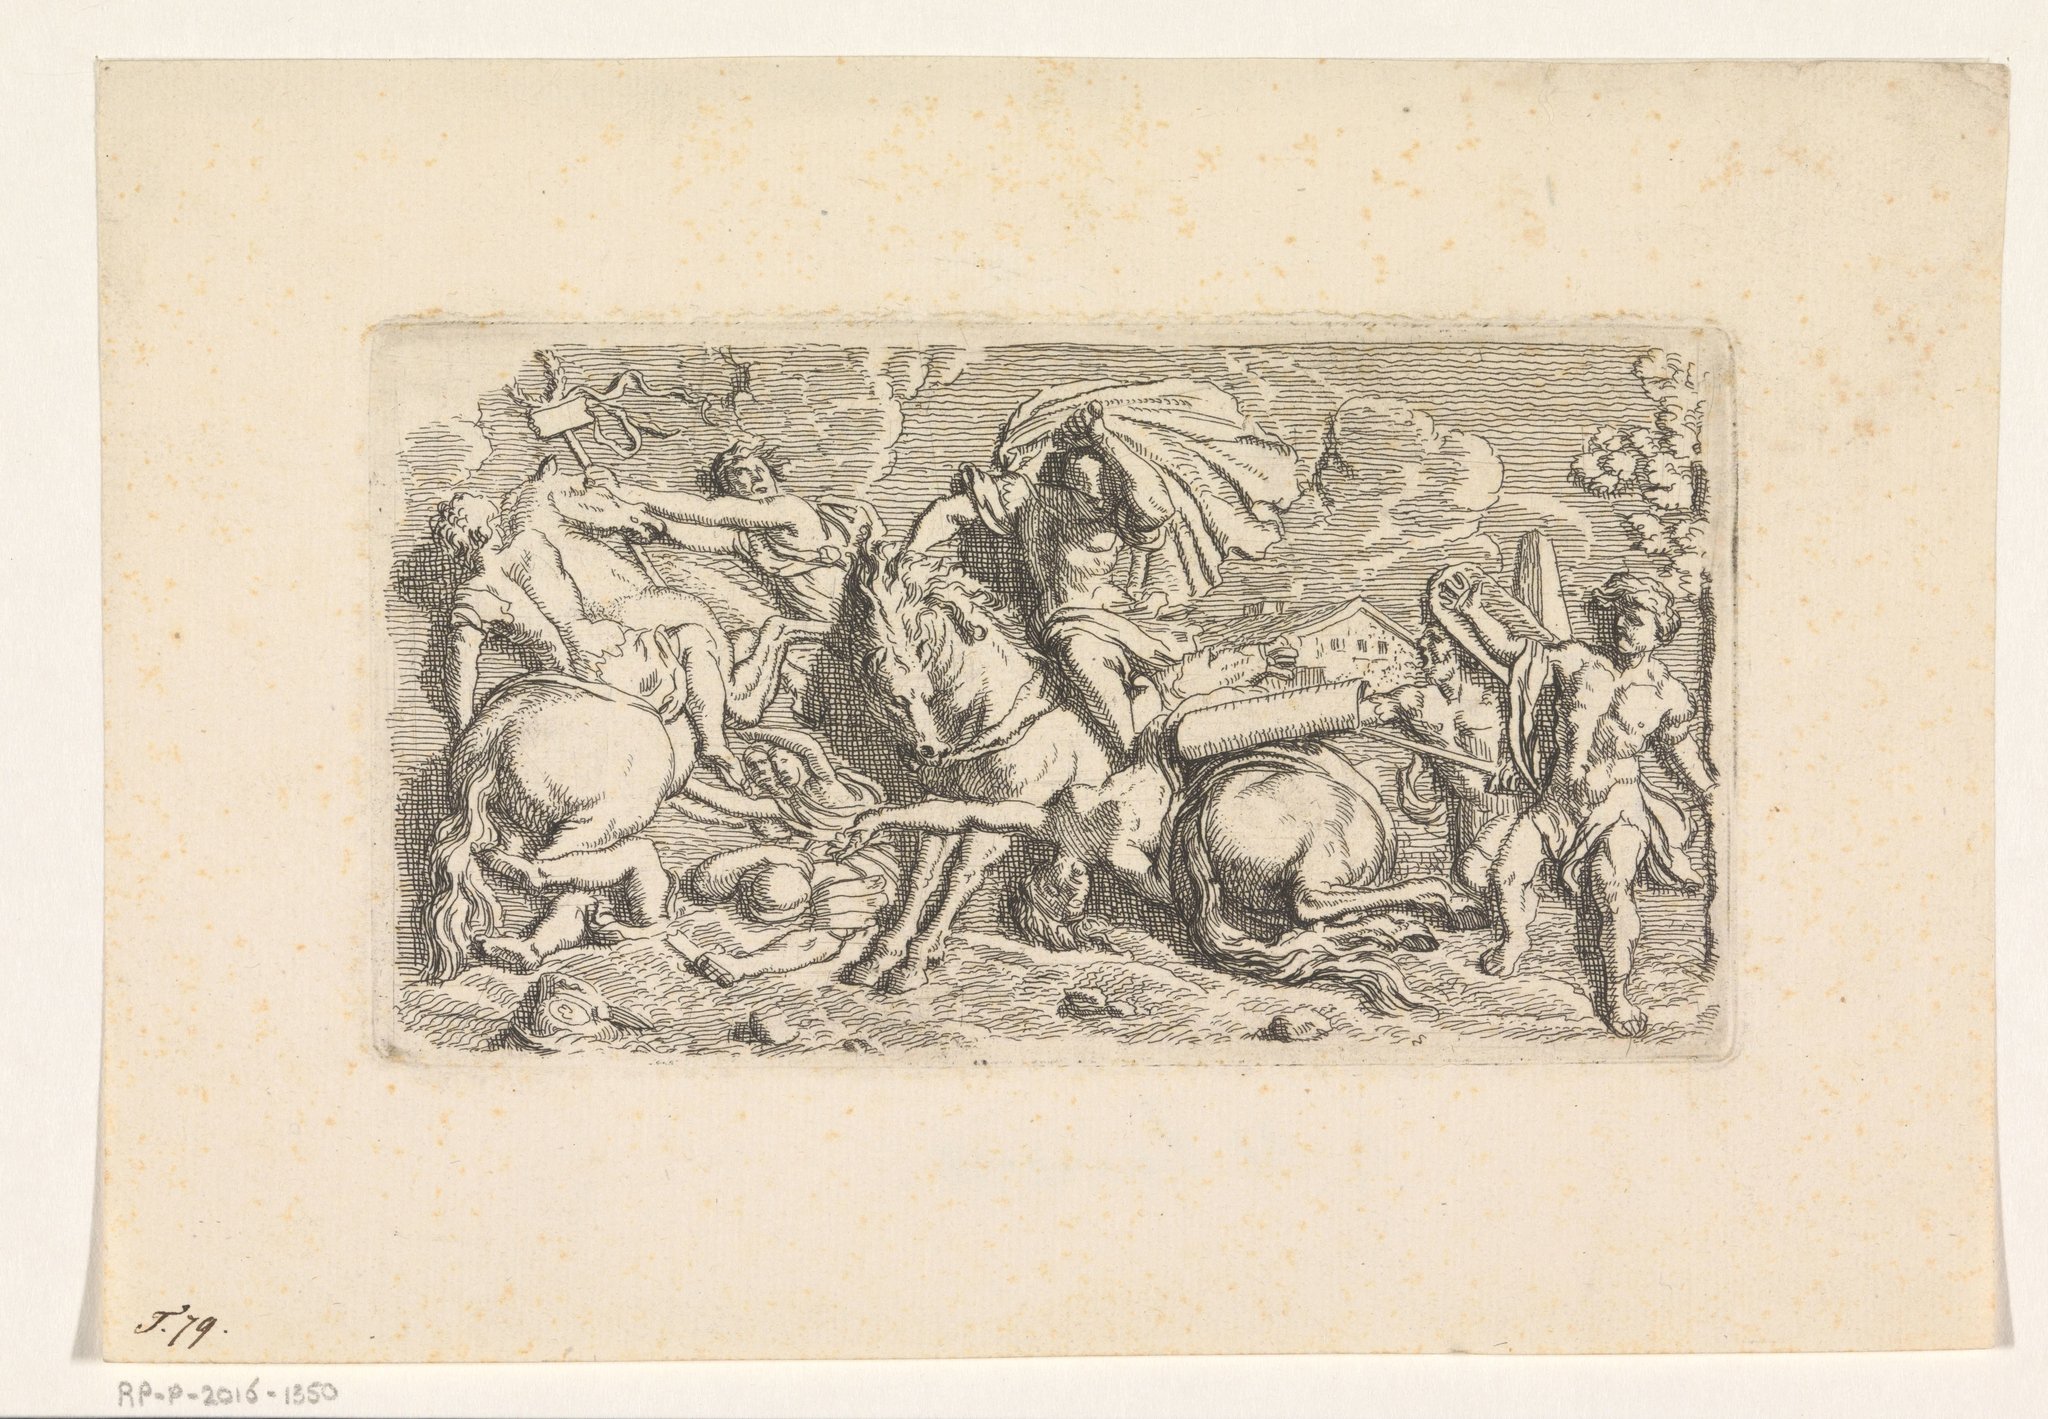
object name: print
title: Amazonenslag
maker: gerard de lairesse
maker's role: draughtsman, painter, print maker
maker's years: 1641-1711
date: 1670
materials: paper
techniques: etching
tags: theseus' fight with the amazons when they attack athens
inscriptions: collector's mark: ‘Hinloopen’, number: ‘T.79’, collector's mark: Lugt 11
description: Theseus bevecht de Amazonen die Athene aanvallen. Antieke reliëfscène in prent gebracht.